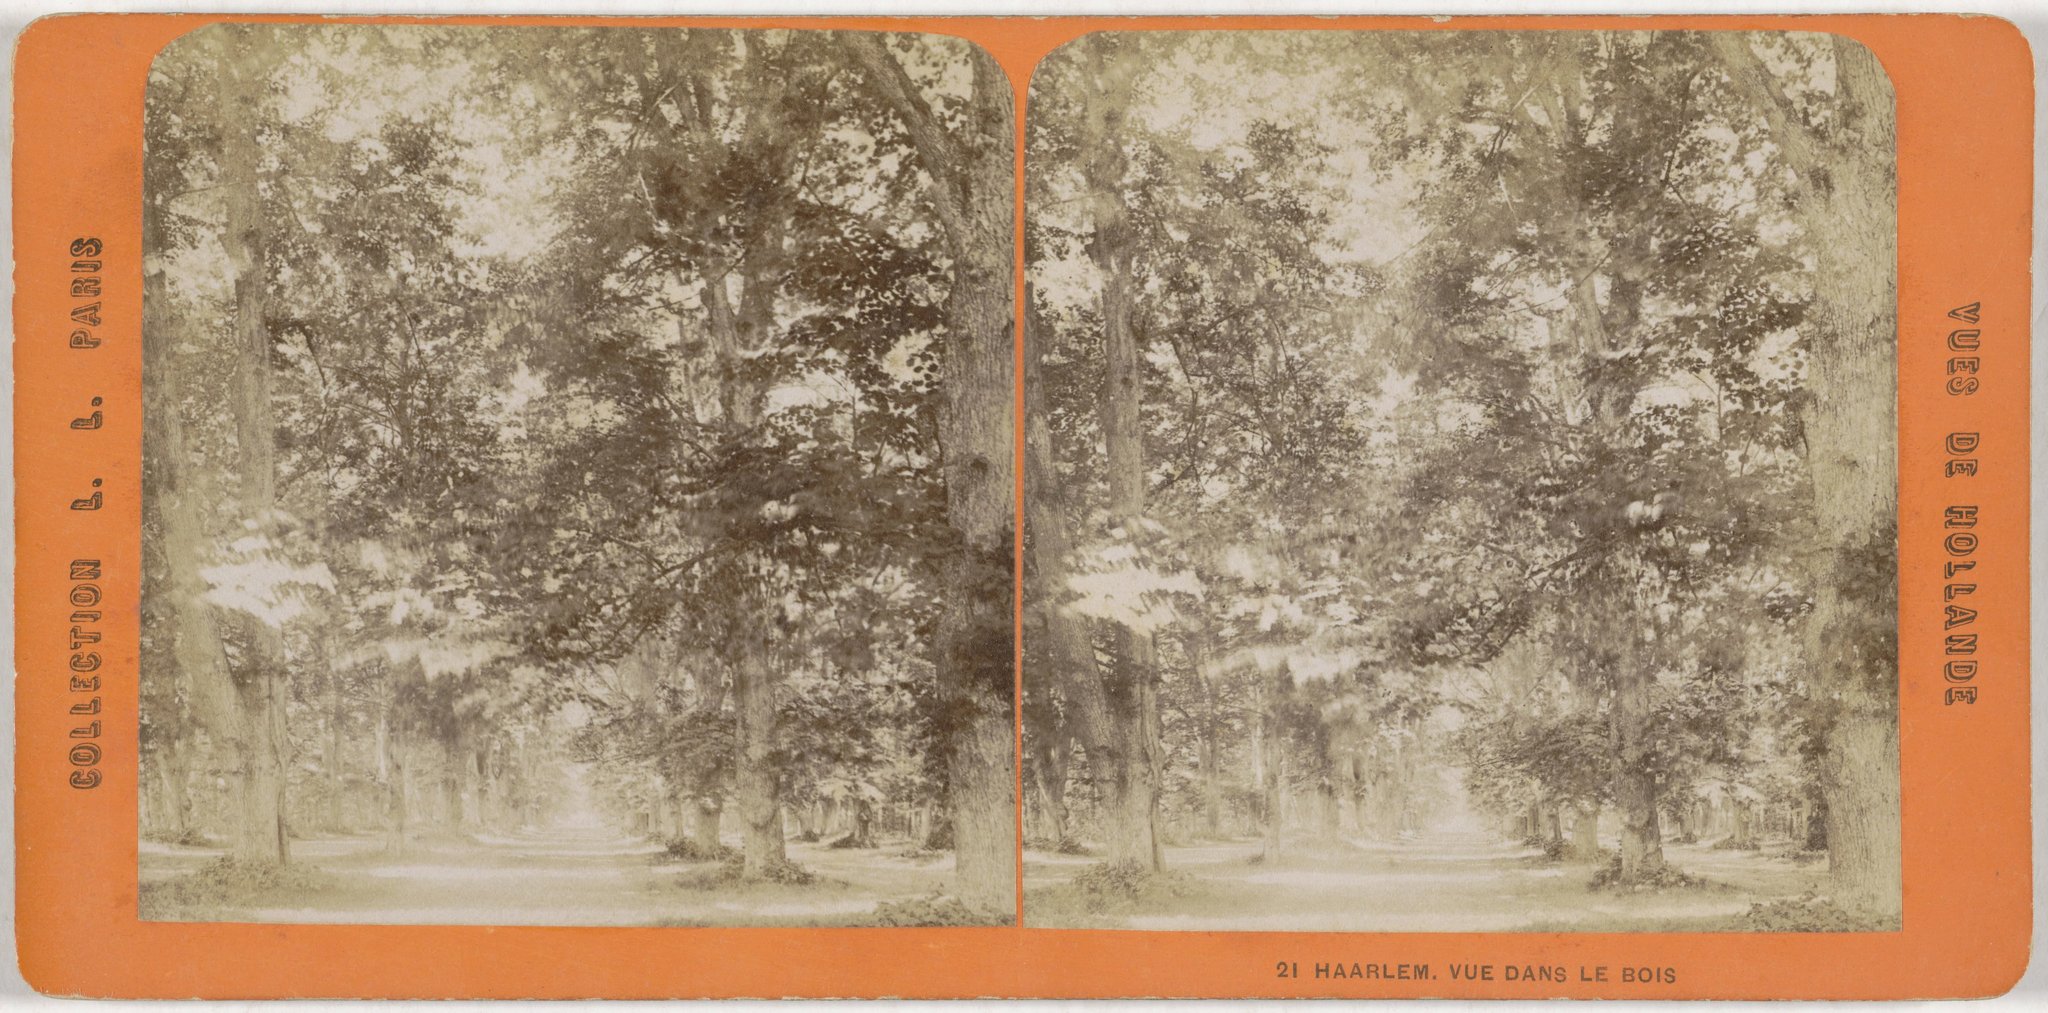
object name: stereograph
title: Boslandschap nabij Haarlem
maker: Anonymous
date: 1873-1890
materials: cardboard, paper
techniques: albumen print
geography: haarlem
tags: forest, wood, haarlem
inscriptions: inscription: ‘RBK’, number: ‘21’